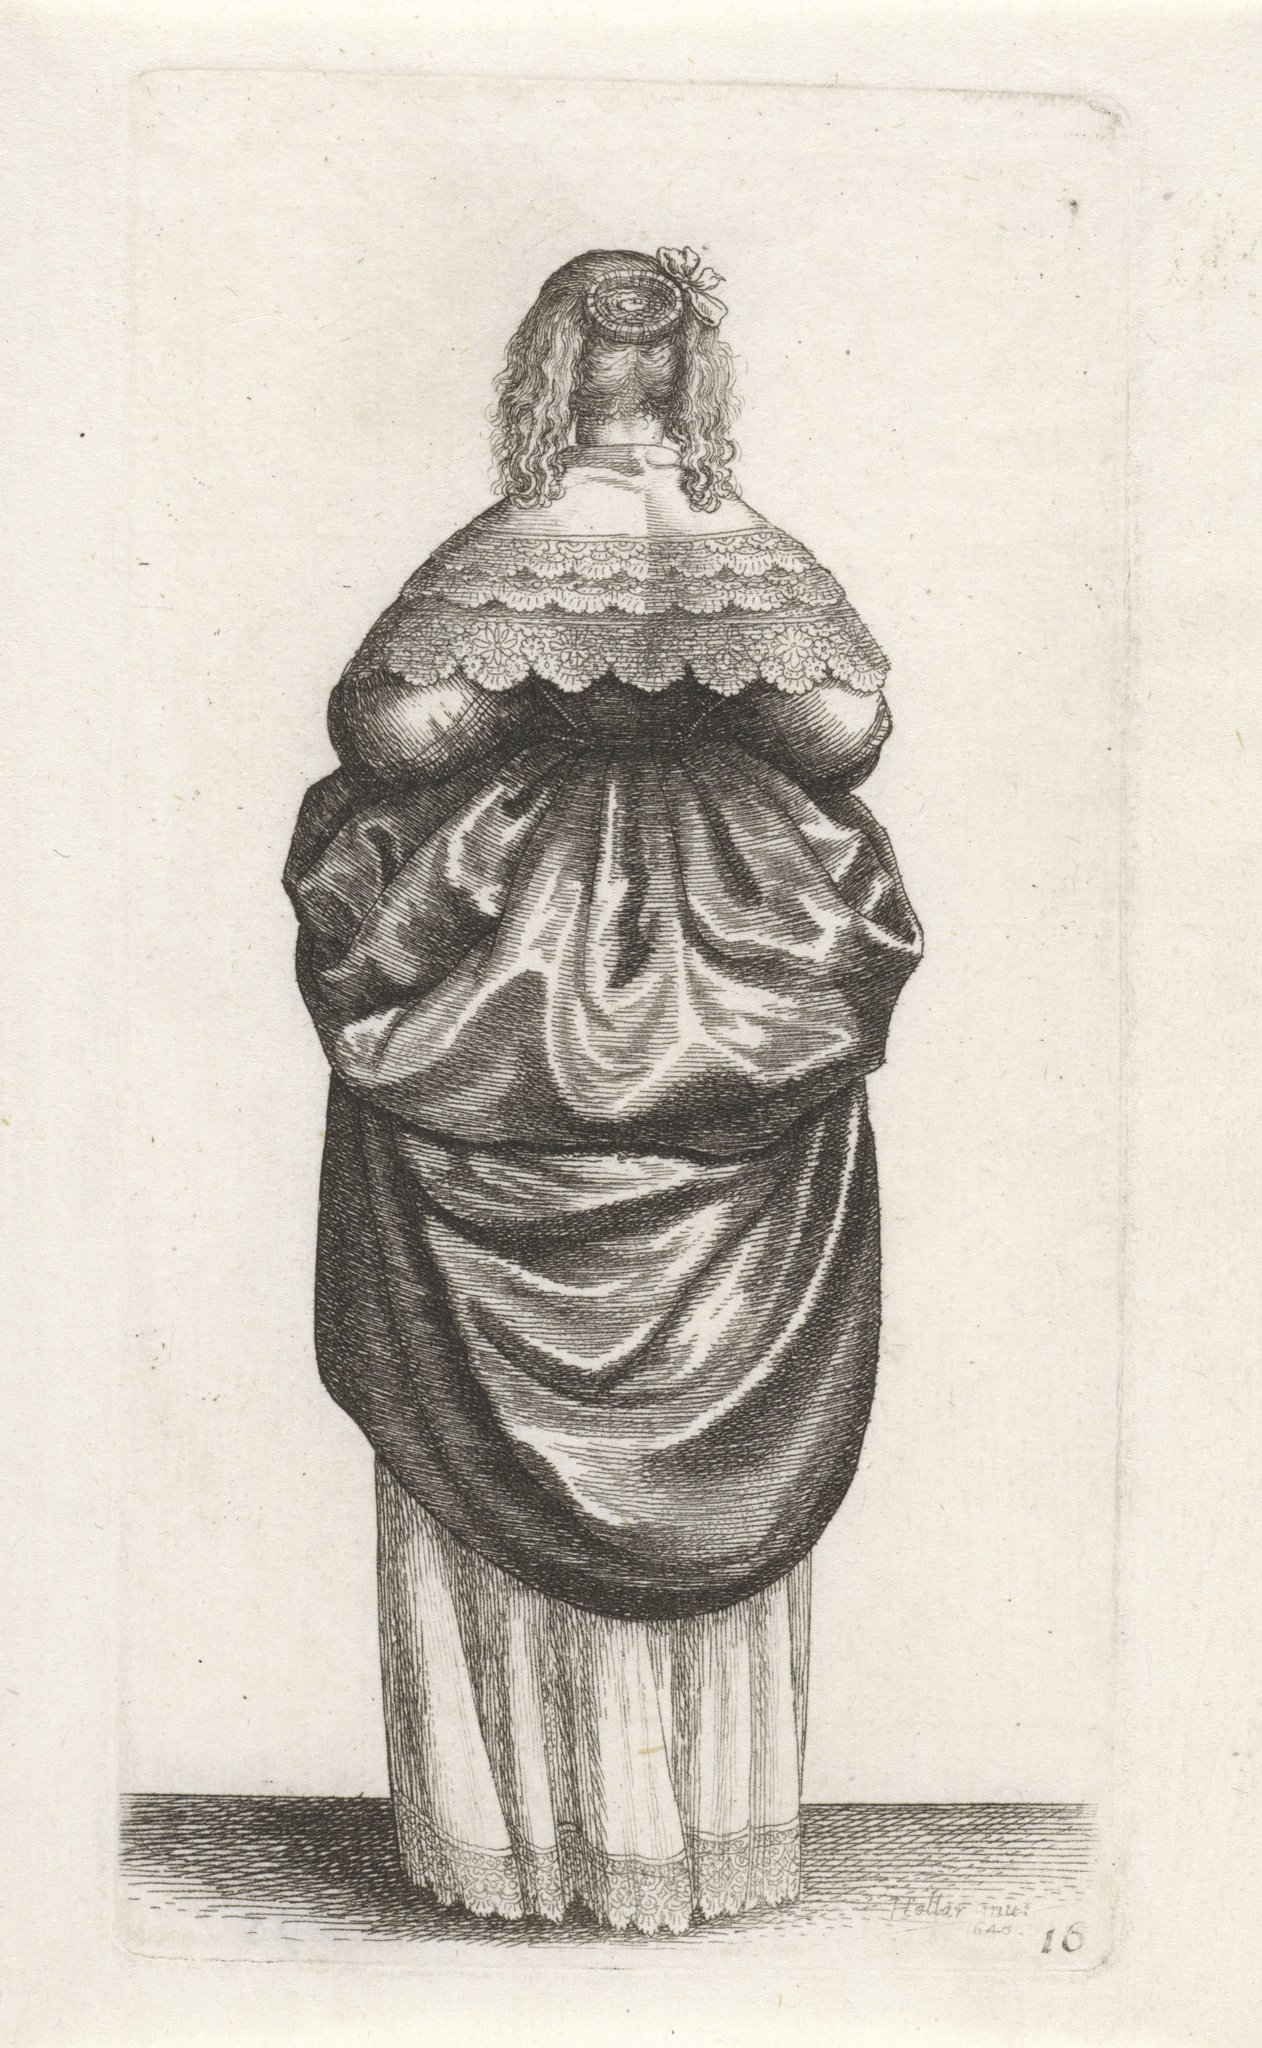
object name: costume print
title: Ornatus Muliebris Anglicanus (The Clothing of English Women)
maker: wenceslaus hollar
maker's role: draughtsman, print maker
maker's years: 1607-1677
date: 1640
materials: paper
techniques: etching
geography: london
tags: neck-gear ~ clothing (neckerchief) (+ women's clothes), europeans: englishmen (+ women), skirt (underskirt) (+ women's clothes), styles of hairdress - aa - ~ women, fashion plates, skirt (+ women's clothes), dress, gown (+ women's clothes), sleeves (+ women's clothes), clothing for the upper part of the body (with name) (+ women's clothes), england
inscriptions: collector's mark: Lugt 654, number: ‘16’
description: The diversity of women’s apparel in England is illustrated in this extensive costume series. Hollar represented women from all ranks of society, from the humble countrywoman 1 to the elegant noblewoman 2. The more fashionable costumes are based on eyewitness observation of the ladies at the court of the Earl of Arundel, Hollar’s primary patron. They are therefore among the more reliable visual sources for costume historians.